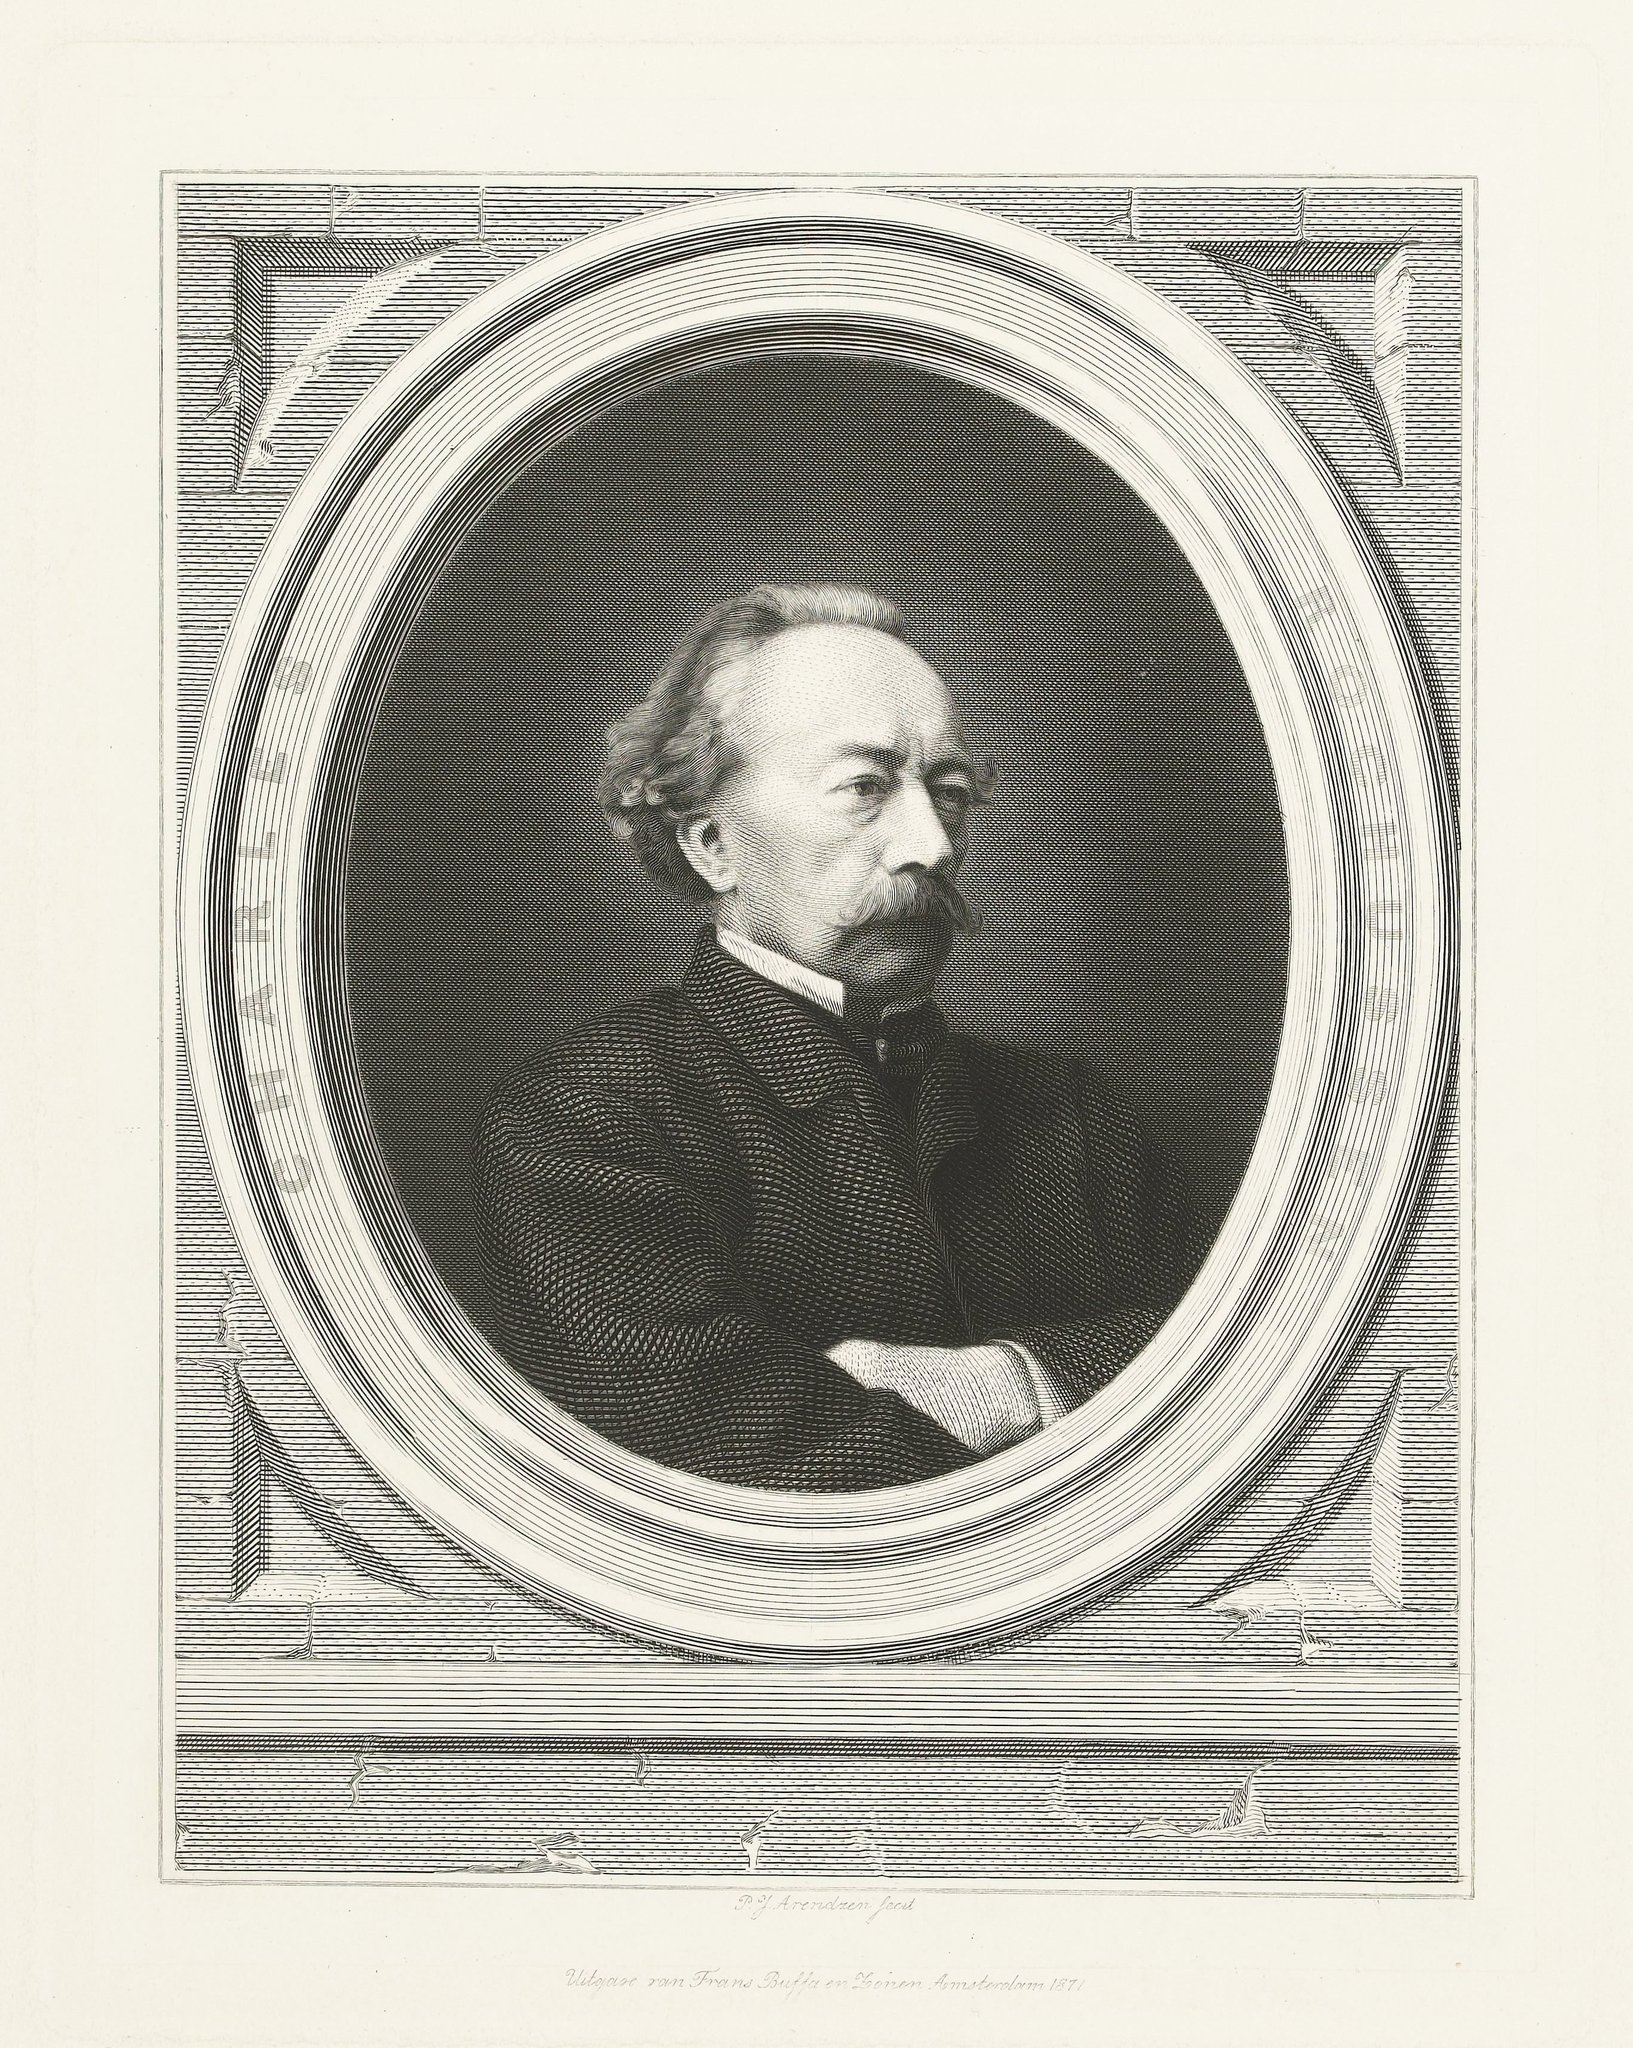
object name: print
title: Portret van Charles Rochussen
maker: petrus johannes arendzen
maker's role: draughtsman, print maker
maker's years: 1846-1932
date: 1871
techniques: printmaking, engraving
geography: amsterdam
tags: rotterdam, painter, print maker, draughtsman, charles rochussen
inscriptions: collector's mark: Lugt 12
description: Borstbeeld van de kunstenaar Charles Rochussen in ovaal.